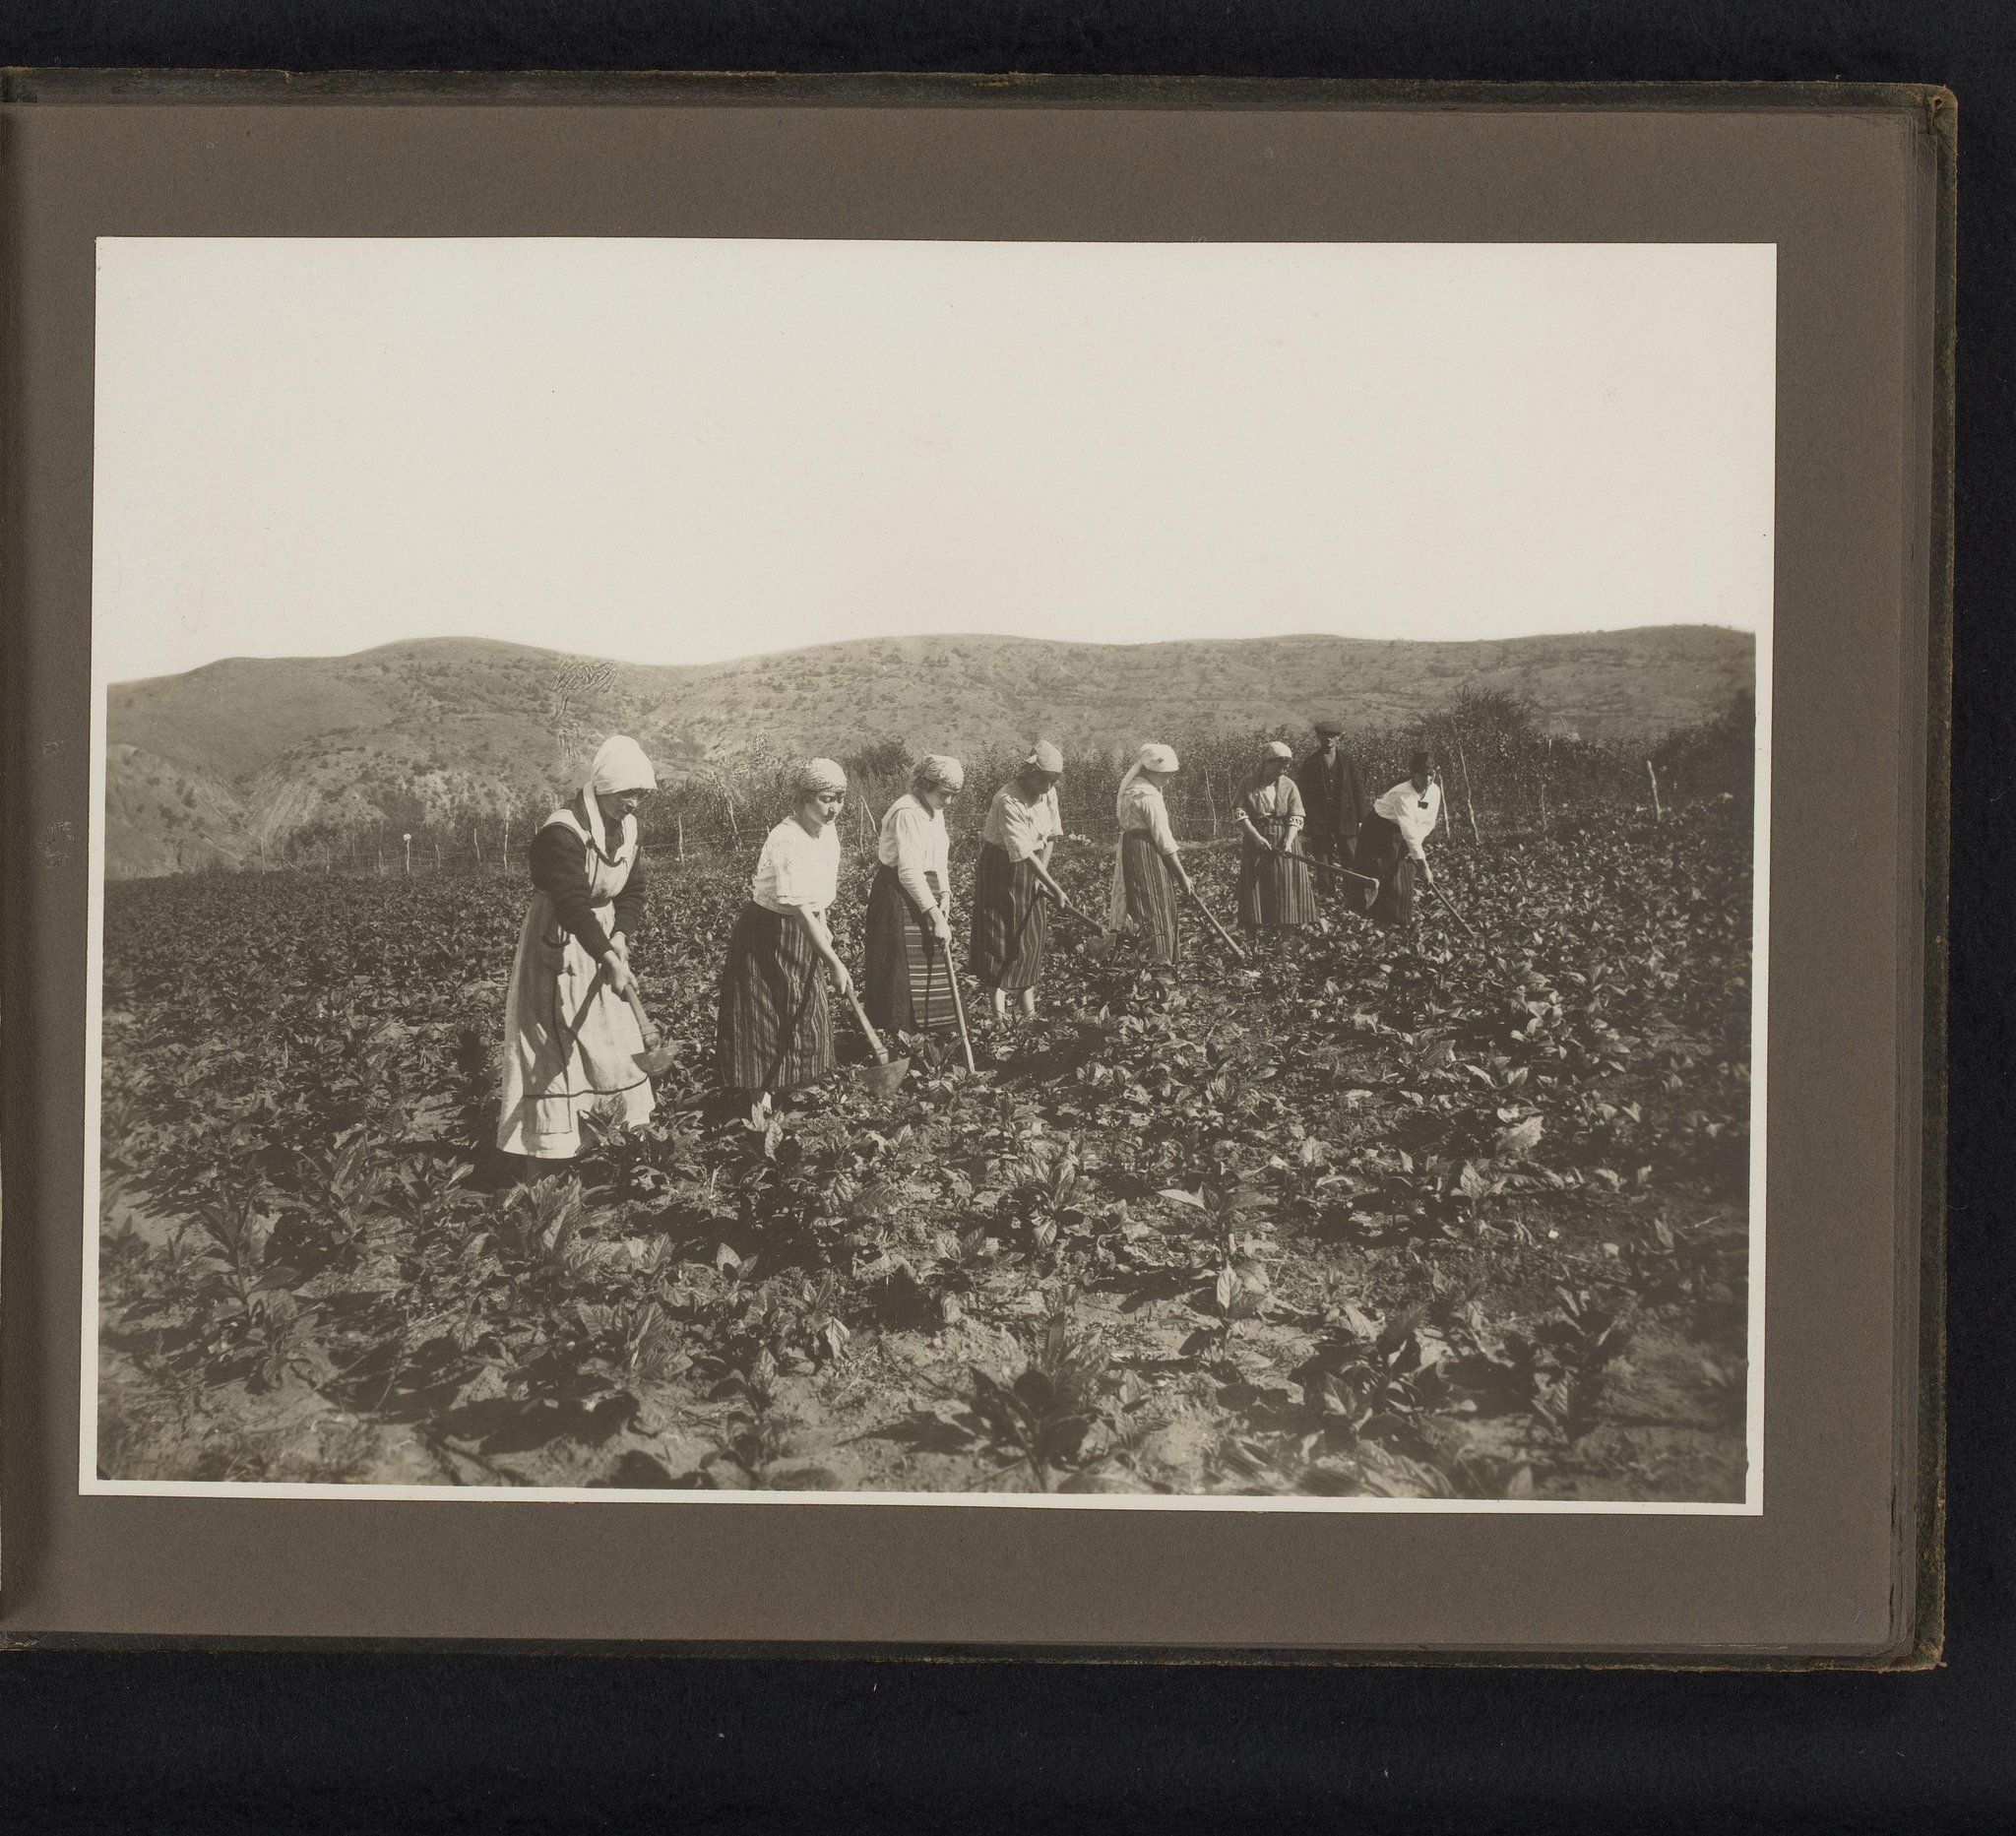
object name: album leaf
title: Vrouwen op de akker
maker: Anonymous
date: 1925-1928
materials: cardboard, photographic support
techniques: gelatin silver print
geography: bulgaria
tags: eugen wachenheimer, (non-fruit) products of plants or trees: tobacco, cultivation ~ agriculture, tobacco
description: Zeven vrouwen verzorgen de nog jonge tabaksplanten, een mannelijke opzichter kijkt toe. Onderdeel van het fotoalbum voor Eugen Wachenheimer bij zijn afscheid als directeur van het filiaal van de Deutsche Bank in Sofia, december 1928.